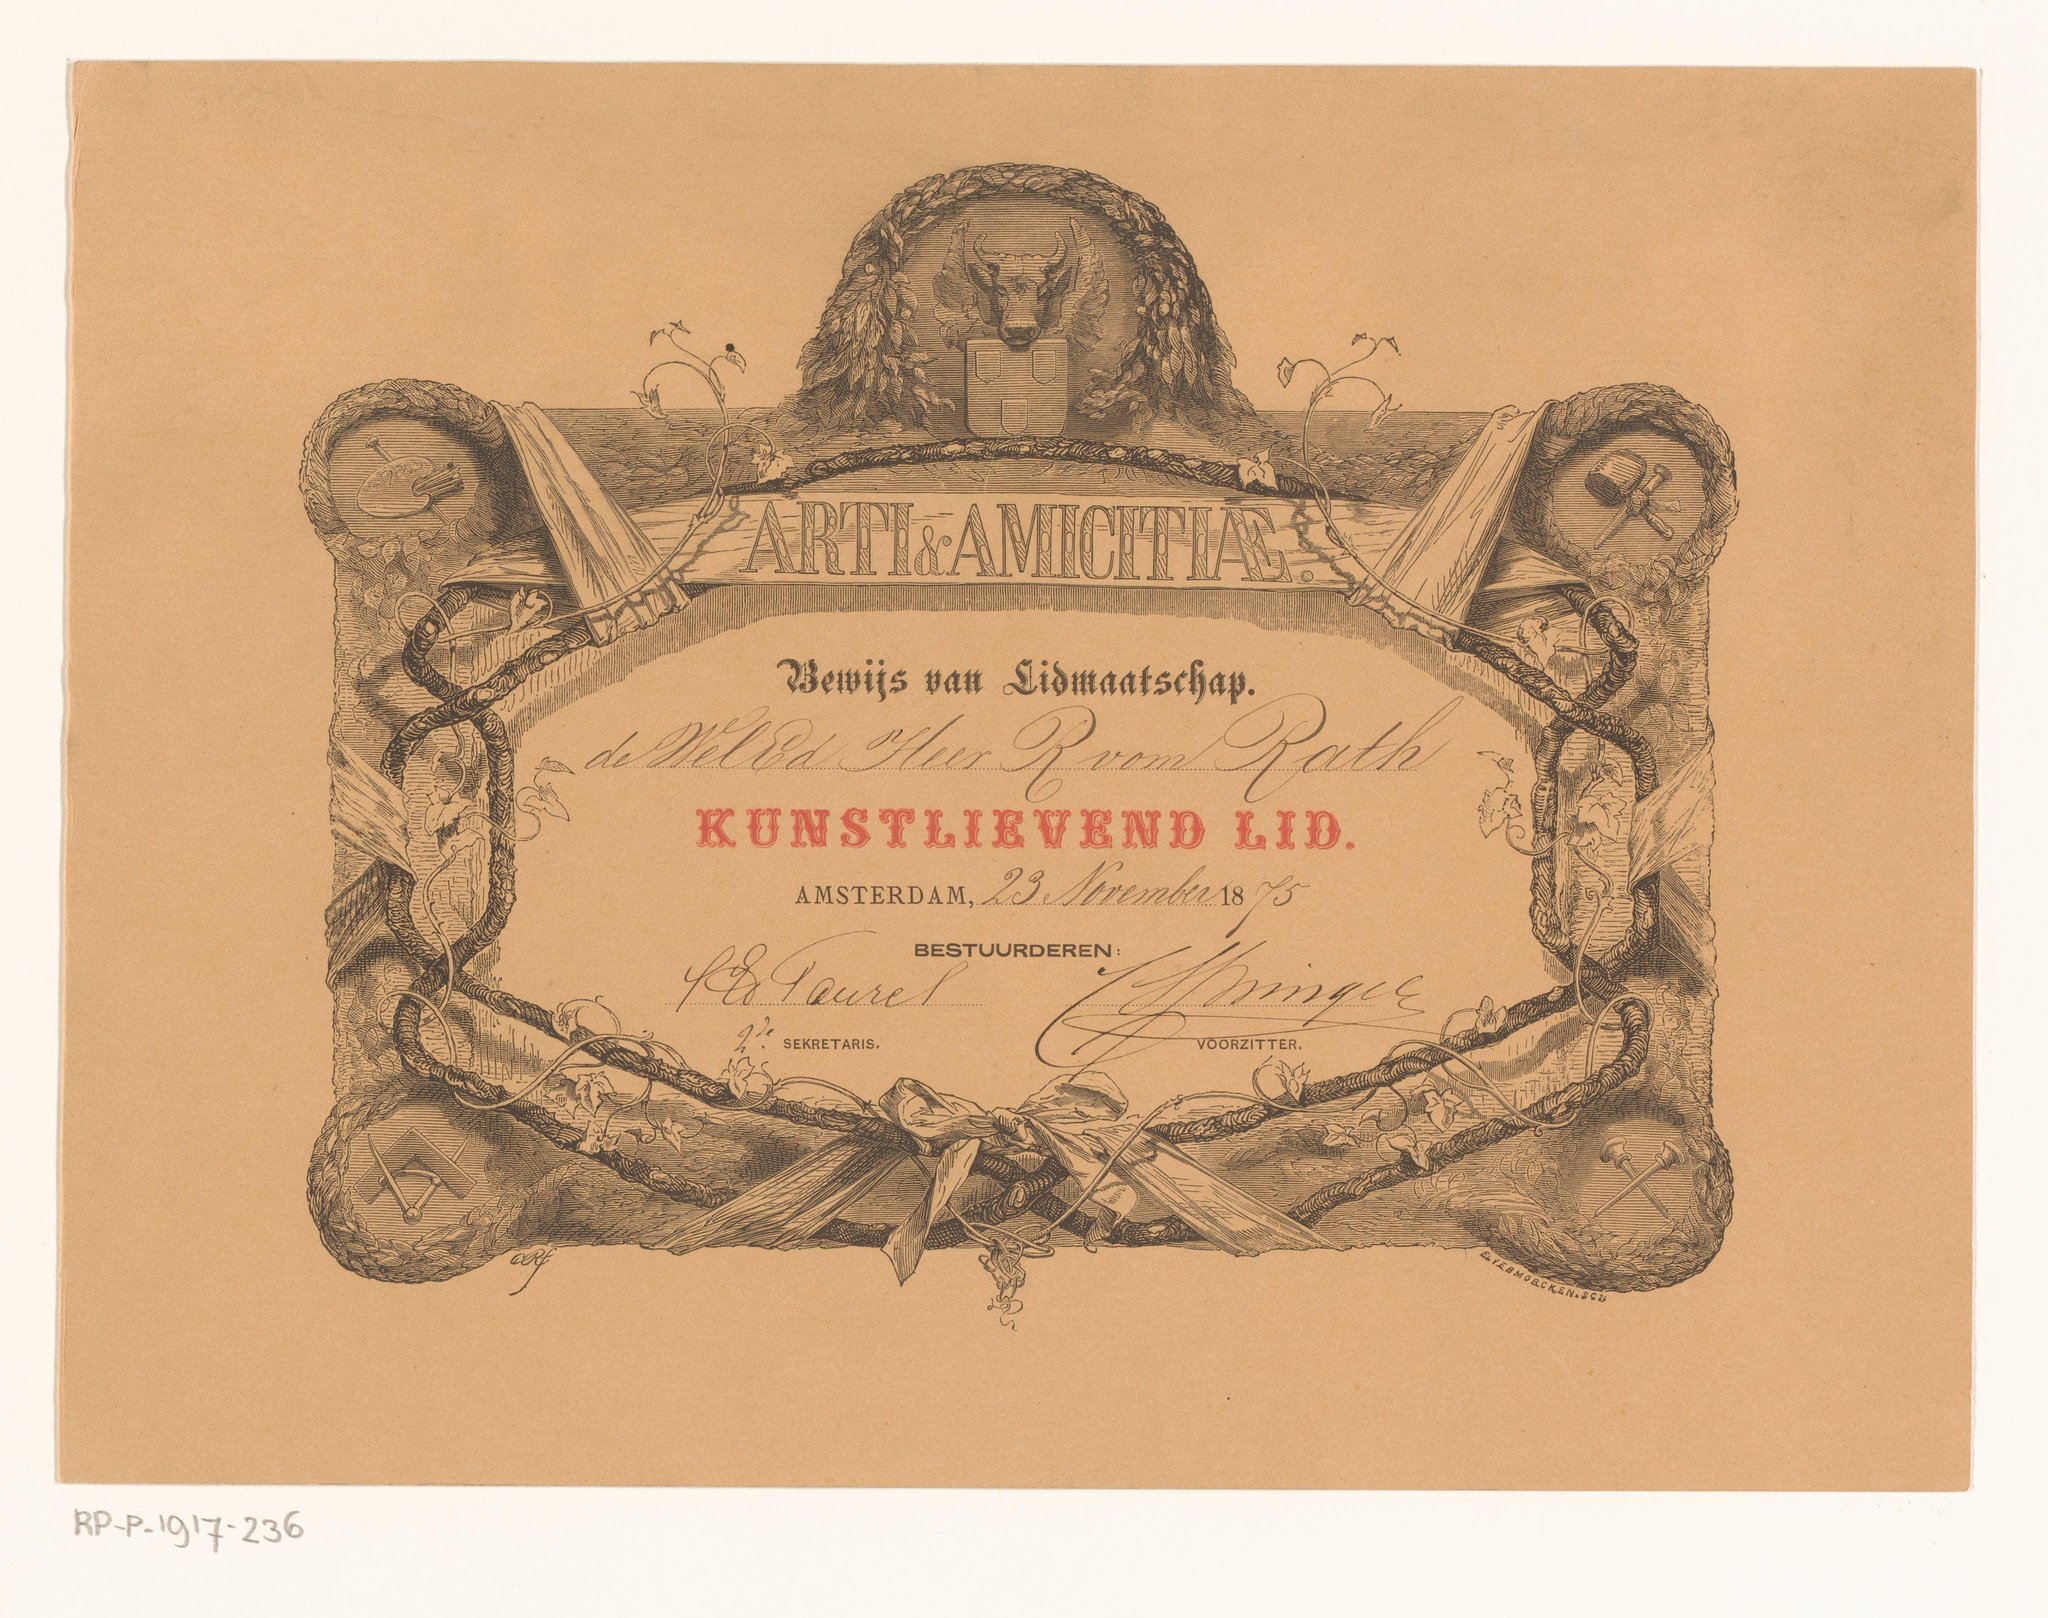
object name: print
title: Bewijs van lidmaatschap van Arti et Amicitiae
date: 1875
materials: paper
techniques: engraving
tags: member, membership, person stimulating the arts; art lover, connoisseur, maecenas, patron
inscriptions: collector's mark: Lugt 2228, inscription: ‘de WelEd Heer R vom Rath (...)’